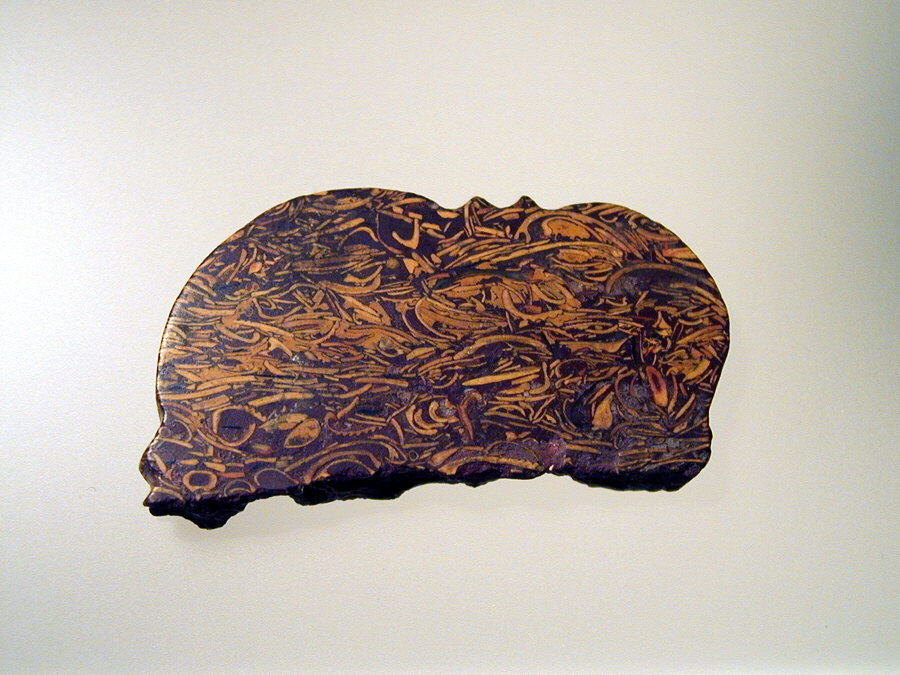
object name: millefiori fragment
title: Glass mosaic fragment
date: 7000 BCE-330 CE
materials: glass